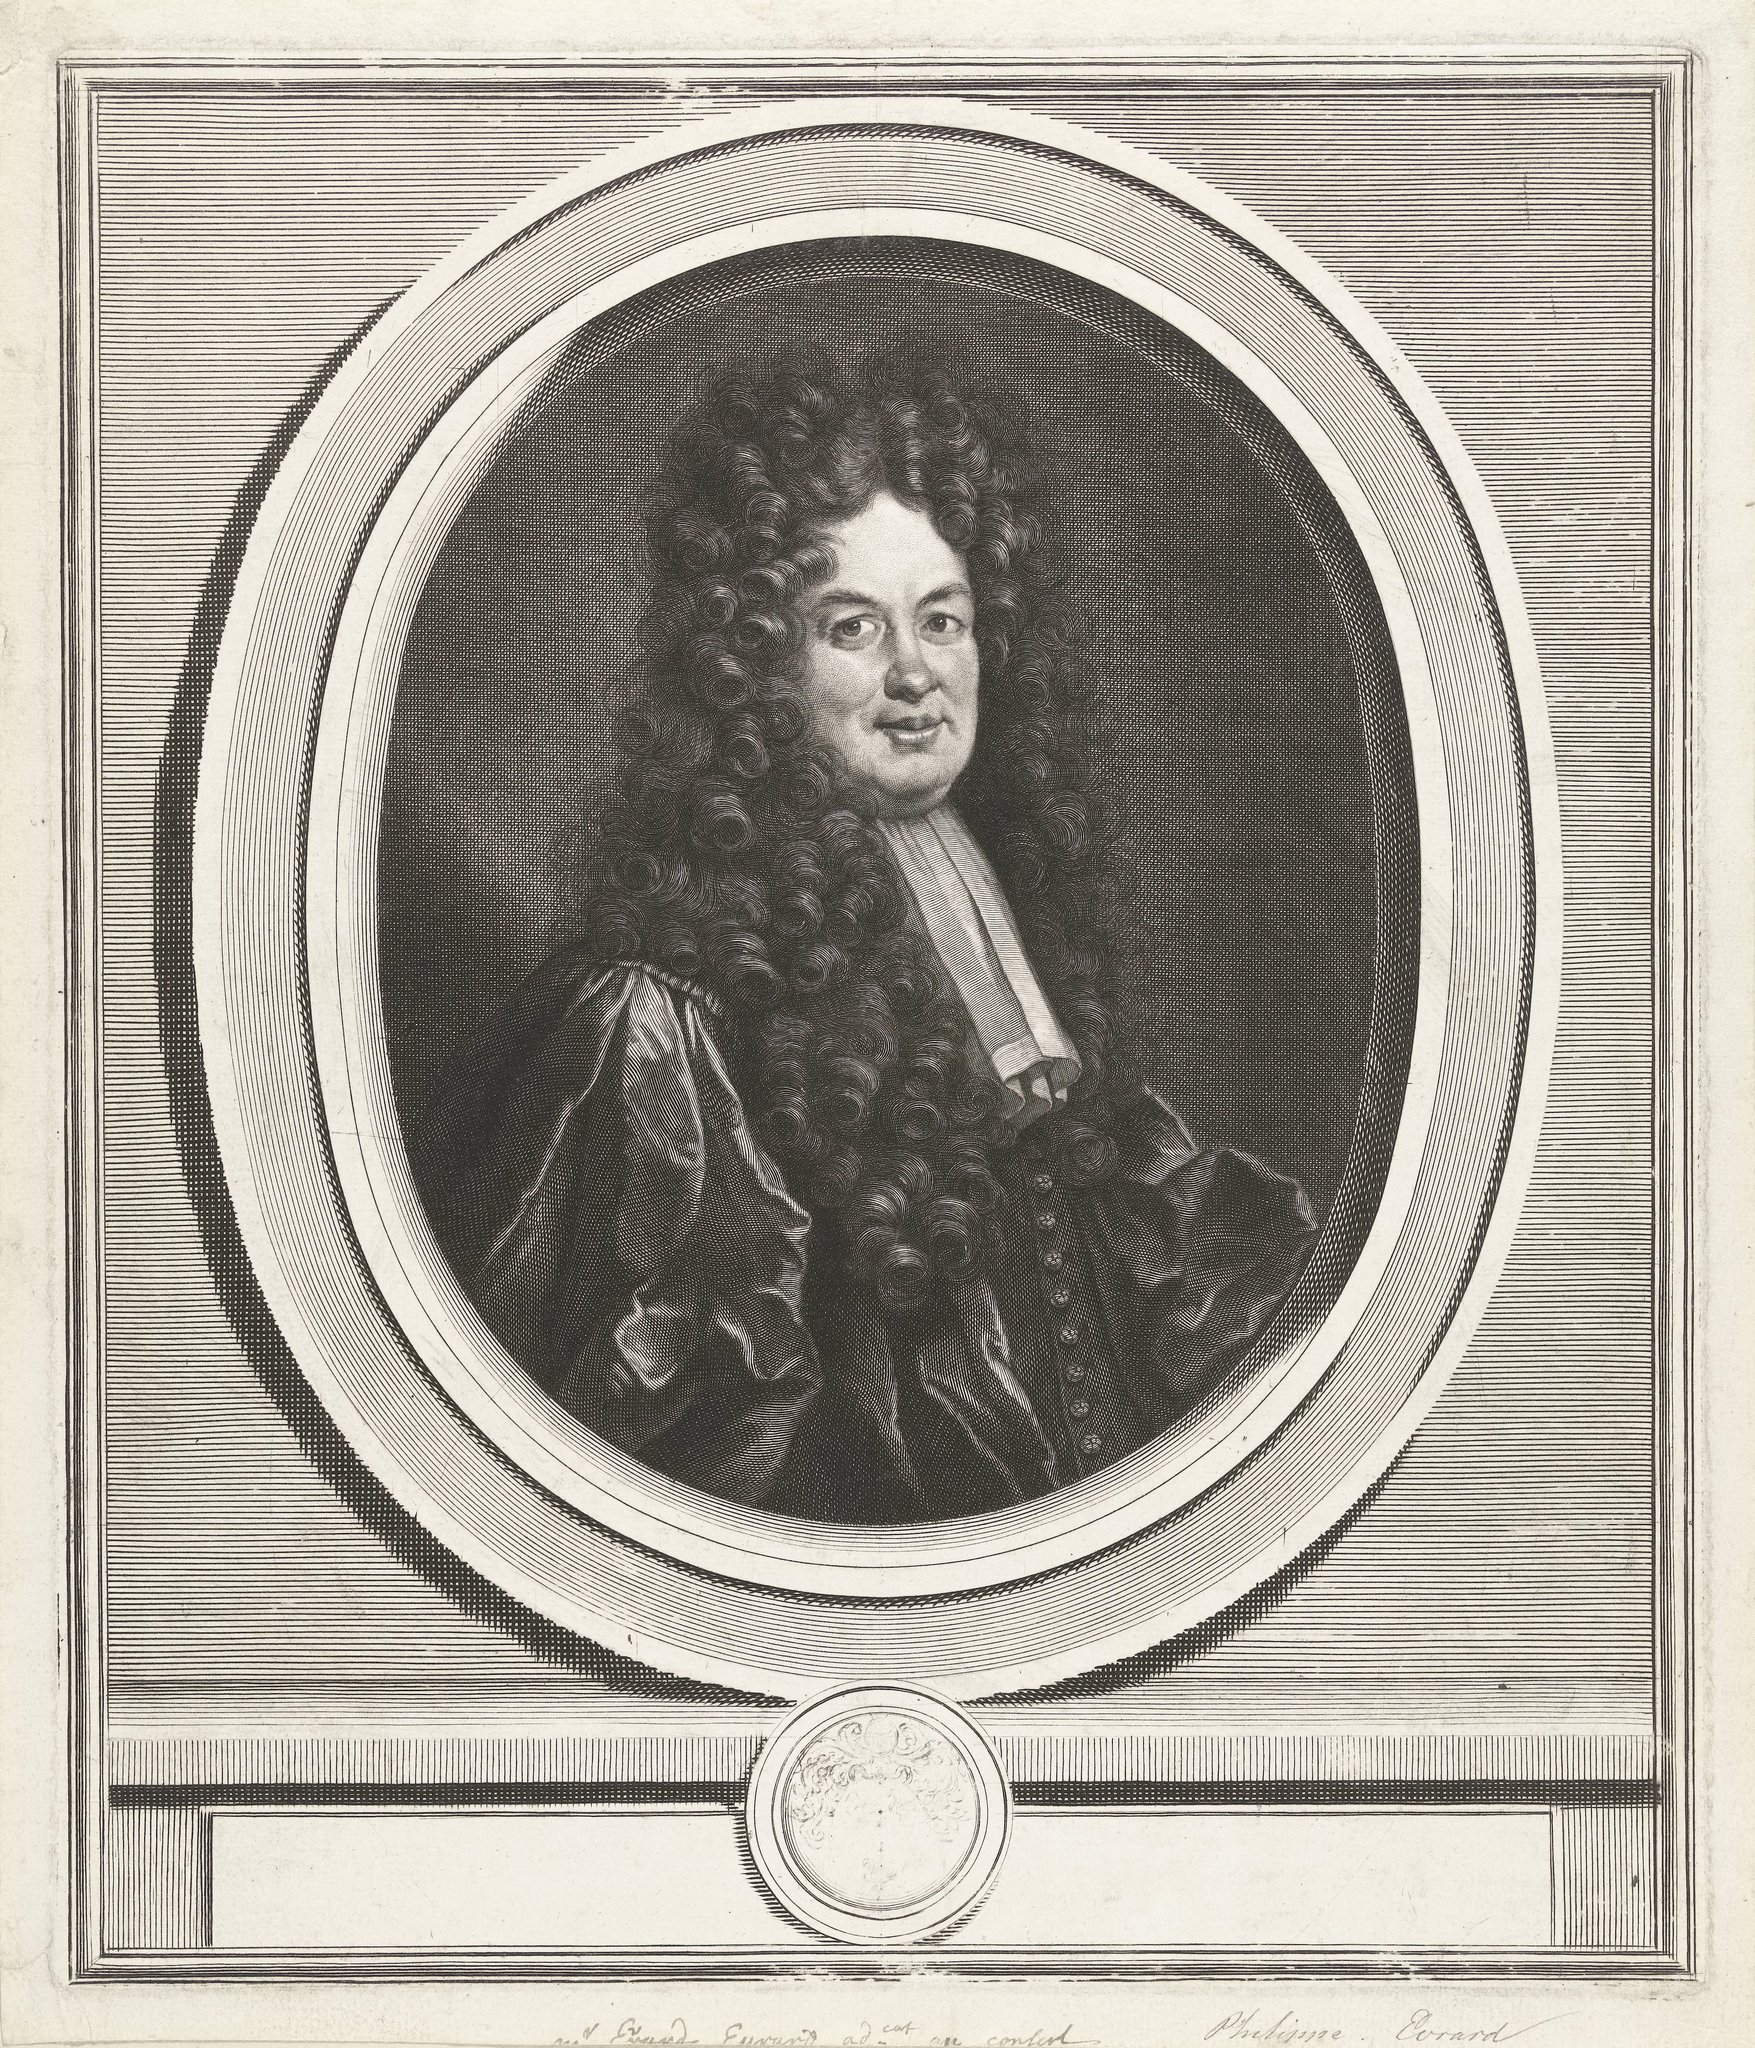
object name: print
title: Portret van Philippe Evrard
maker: gerard edelinck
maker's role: print maker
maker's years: 1640-1707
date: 1652-1707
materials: paper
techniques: engraving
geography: france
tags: philippe evrard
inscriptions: collector's mark: Lugt 240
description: Philippe Evrard, ten halven lijve afgebeeld in ovale omlijsting met rond cartouche waarin incompleet wapen.